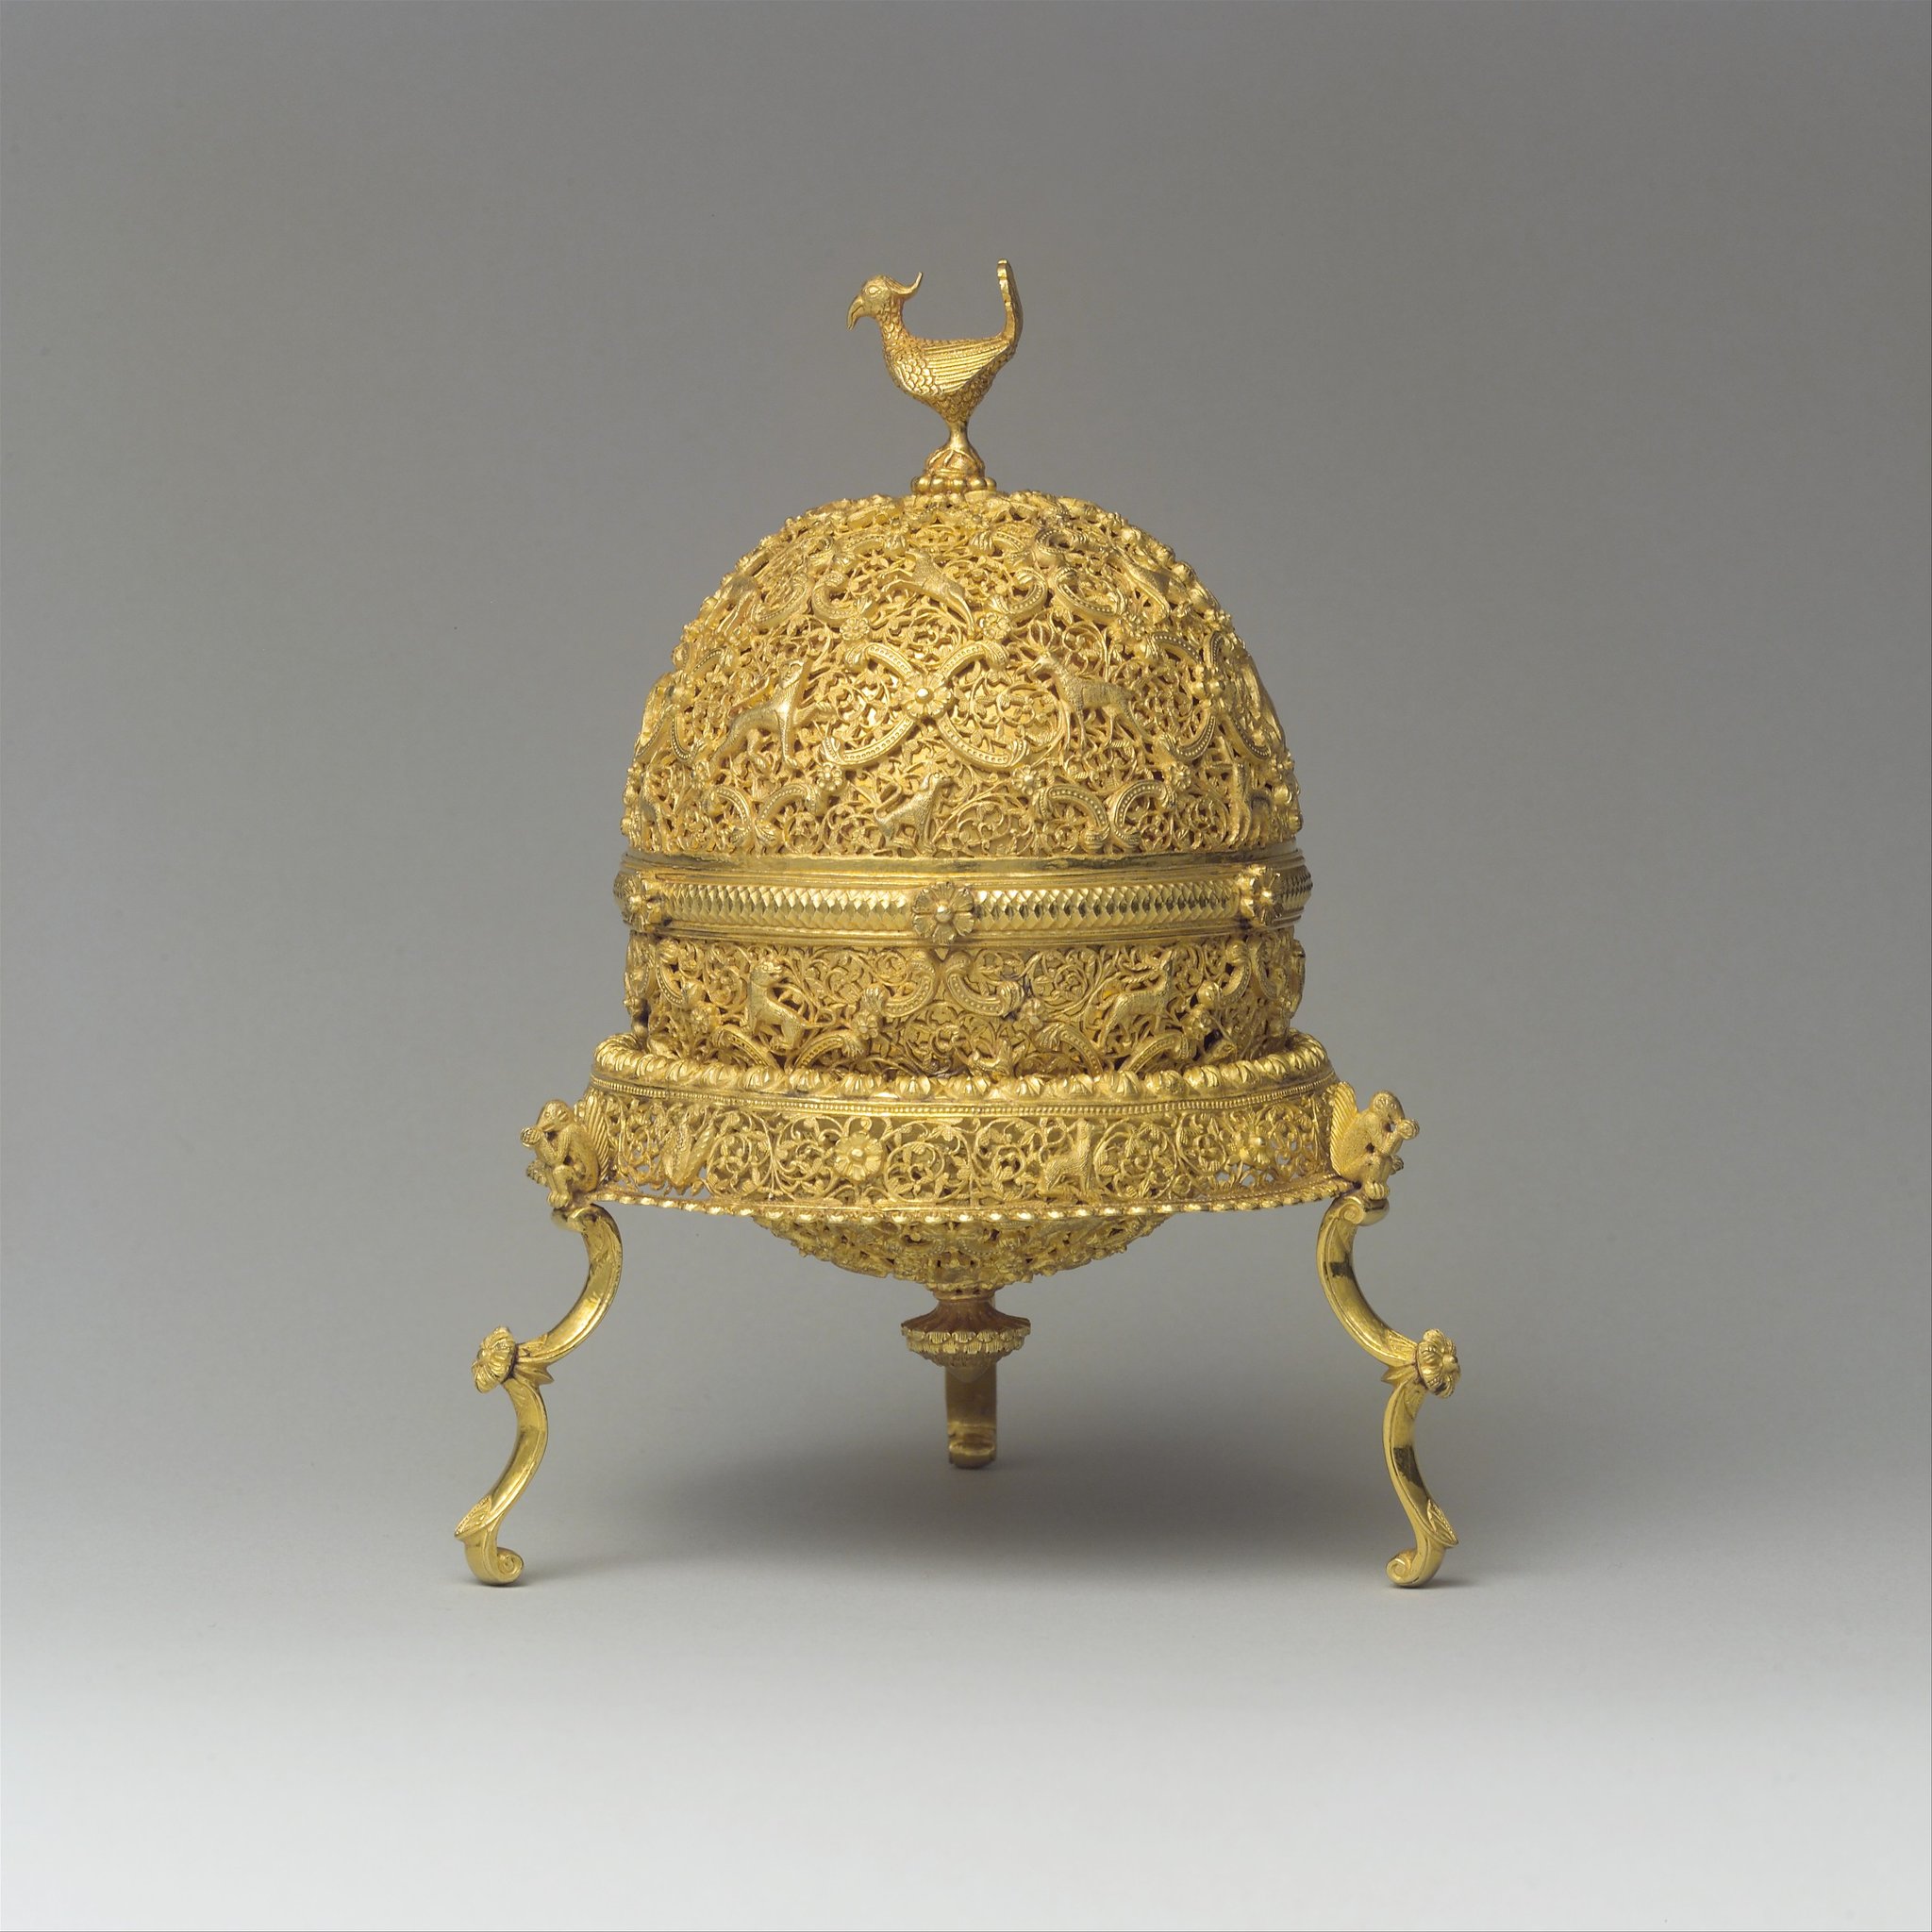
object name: goa stone and container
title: Goa Stone and Gold Case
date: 1667-1733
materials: gold, stone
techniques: casting, repoussé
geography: india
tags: animals,griffins,peacocks,dogs,monkeys,flowers